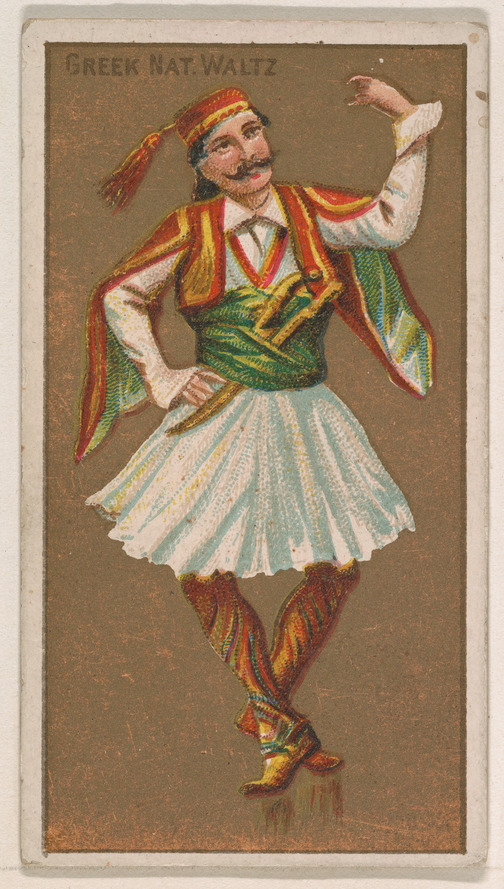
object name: print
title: Greek National Waltz, from National Dances (N225, Type 1) issued by Kinney Bros.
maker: kinney brothers tobacco company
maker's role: publisher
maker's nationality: american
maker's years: 1869-2011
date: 1889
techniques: color lithograph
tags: dance,men,dancers